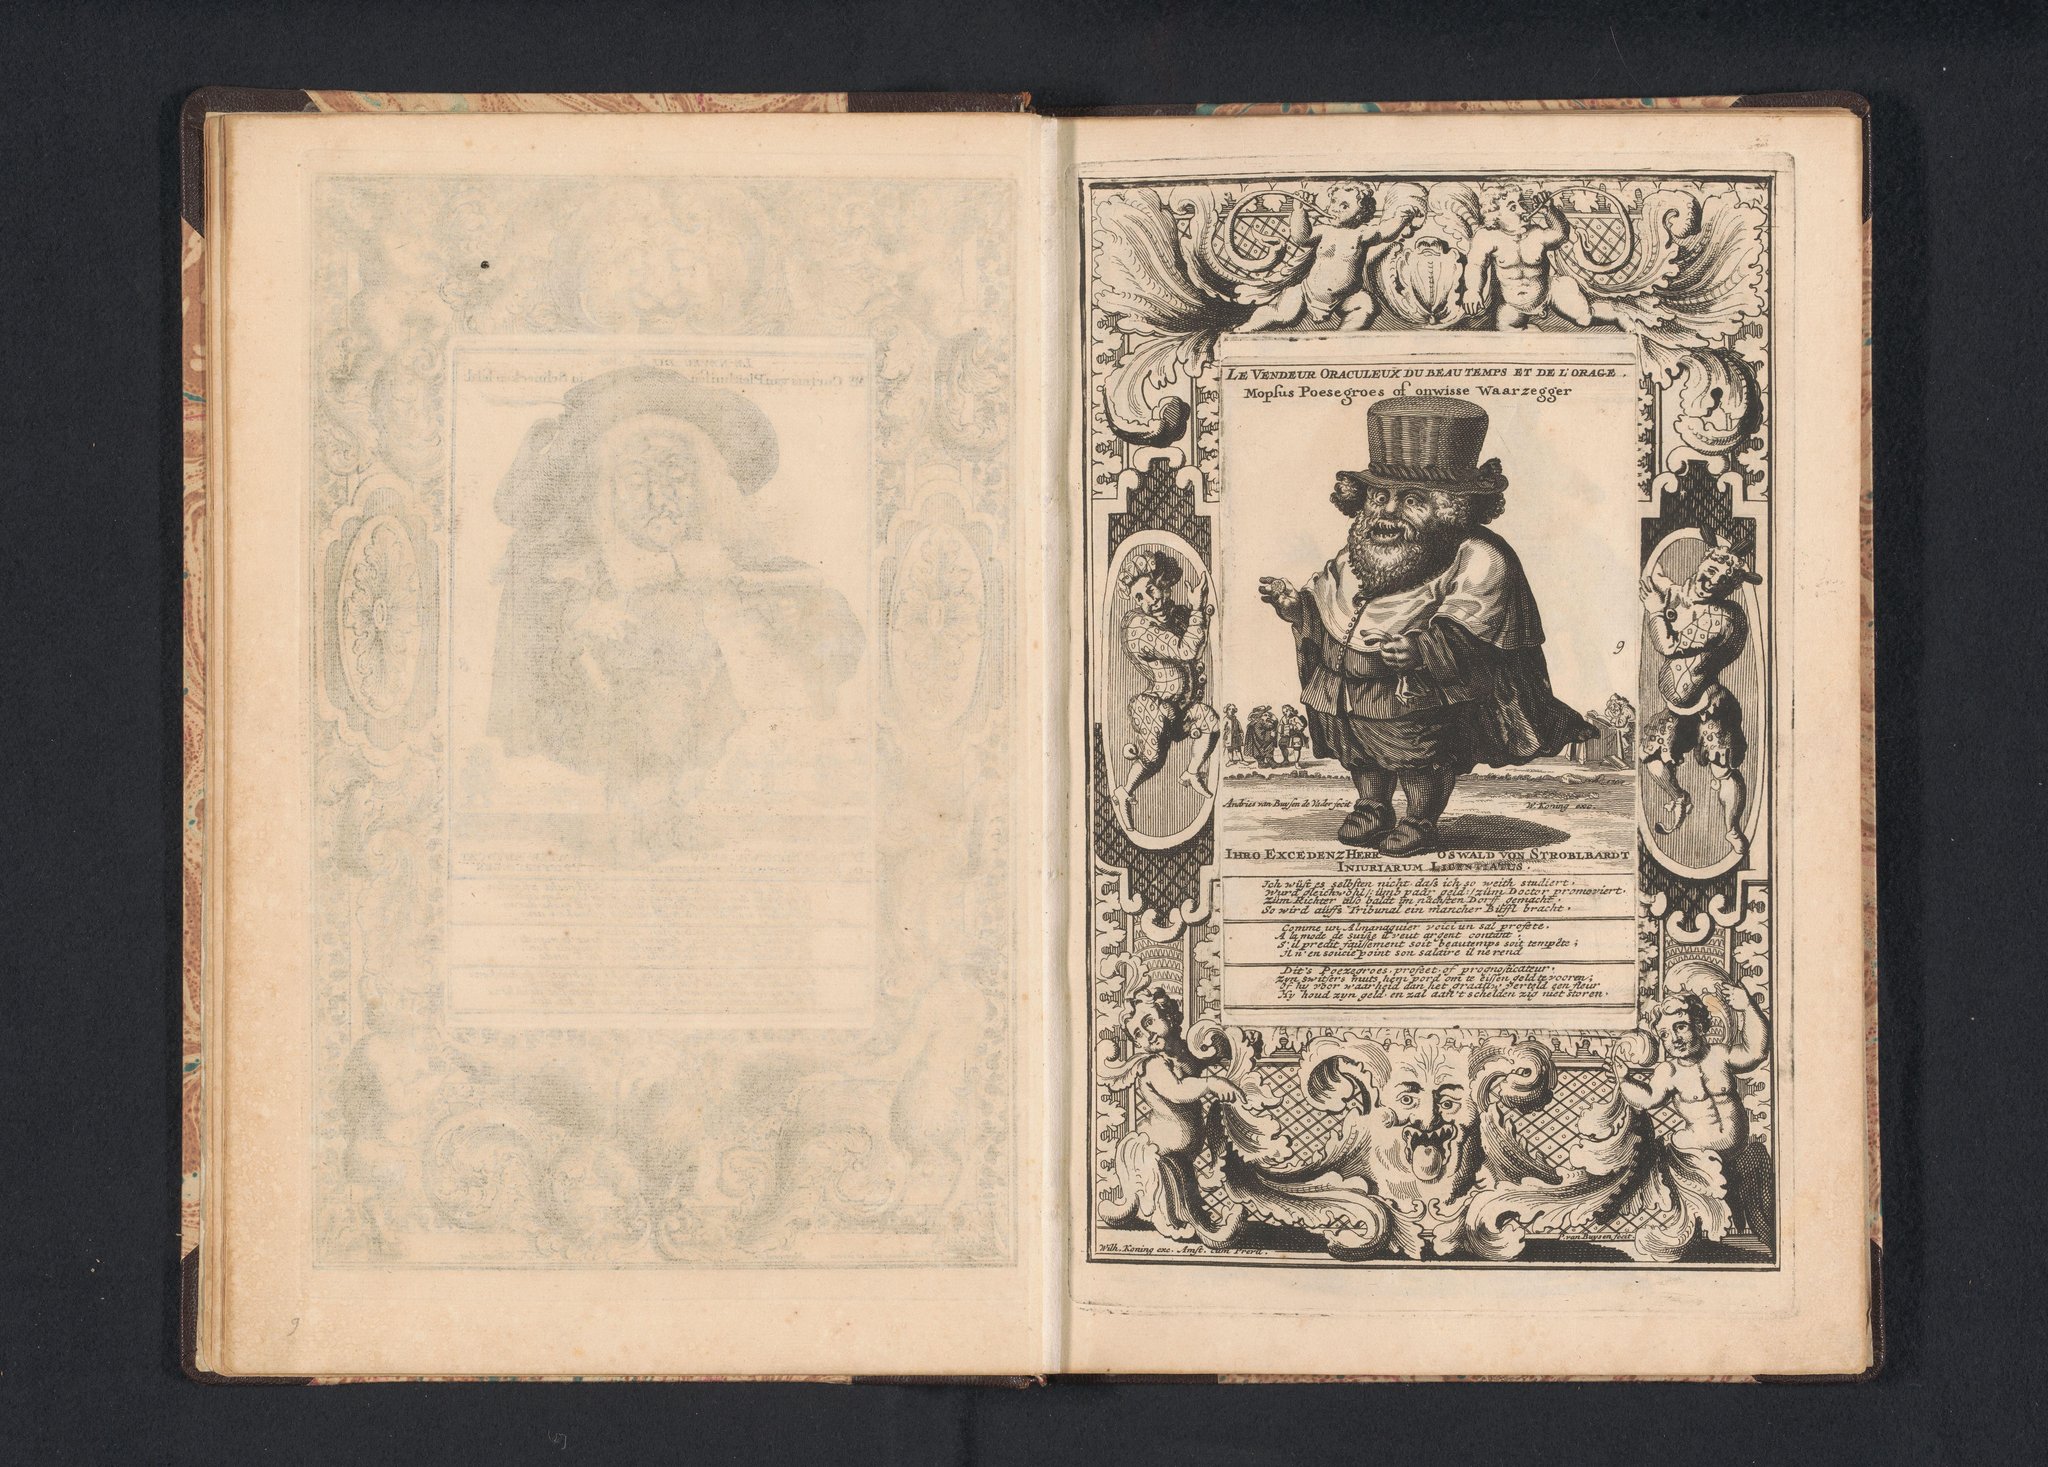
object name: caricature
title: De dwerg Mopsus Poesegroes, 1716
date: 1716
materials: paper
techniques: etching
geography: northern netherlands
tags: caricatures (human types), little people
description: De kleine mens Mopsus Poesegroes als waarzegger met een geldstuk in de hand. In het onderschrift verzen in het Duits, Frans en Nederlands. Afdruk binnen een decoratieve omlijsting gedrukt van een aparte plaat met bladwerk, harlekijnen en engeltjes met bazuinen. Genummerd rechts midden: 9. Onderdeel van de Nederlandse gebonden uitgave uit 1716 van een serie karikaturen van kleine mensen, bekend als Het Dwergentooneel, gekopieerd naar een ouder Duits voorbeeld.